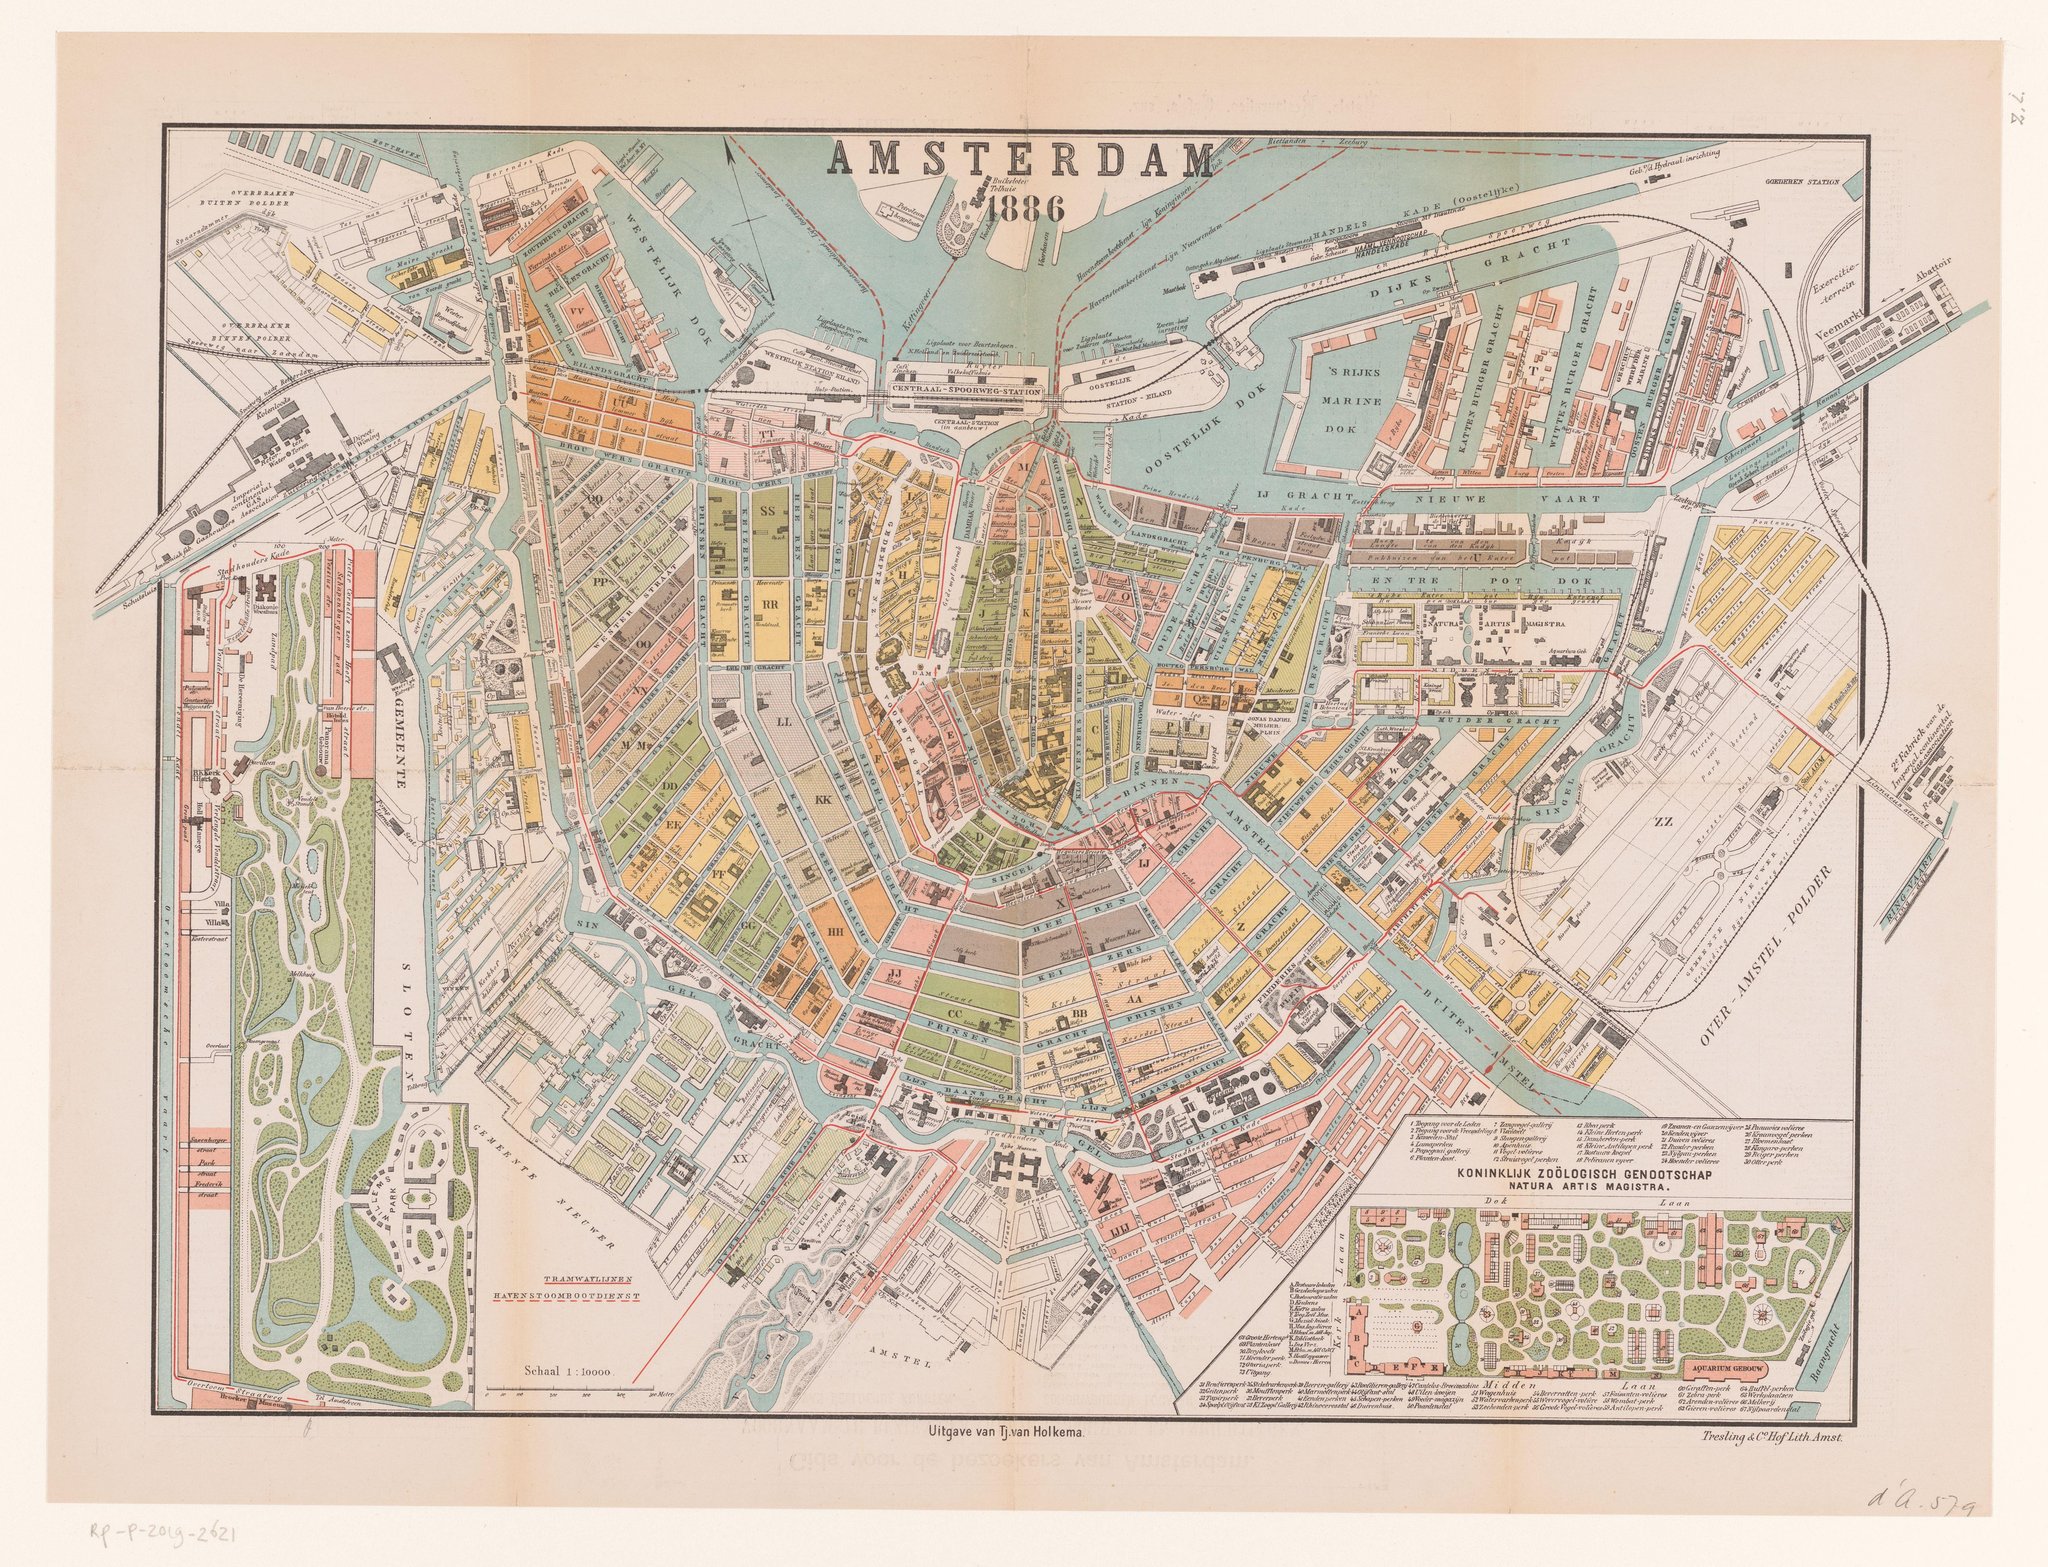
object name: area plan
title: Amsterdam 1886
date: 1886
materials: paper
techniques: lithograph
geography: amsterdam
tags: maps of cities, amsterdam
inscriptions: date